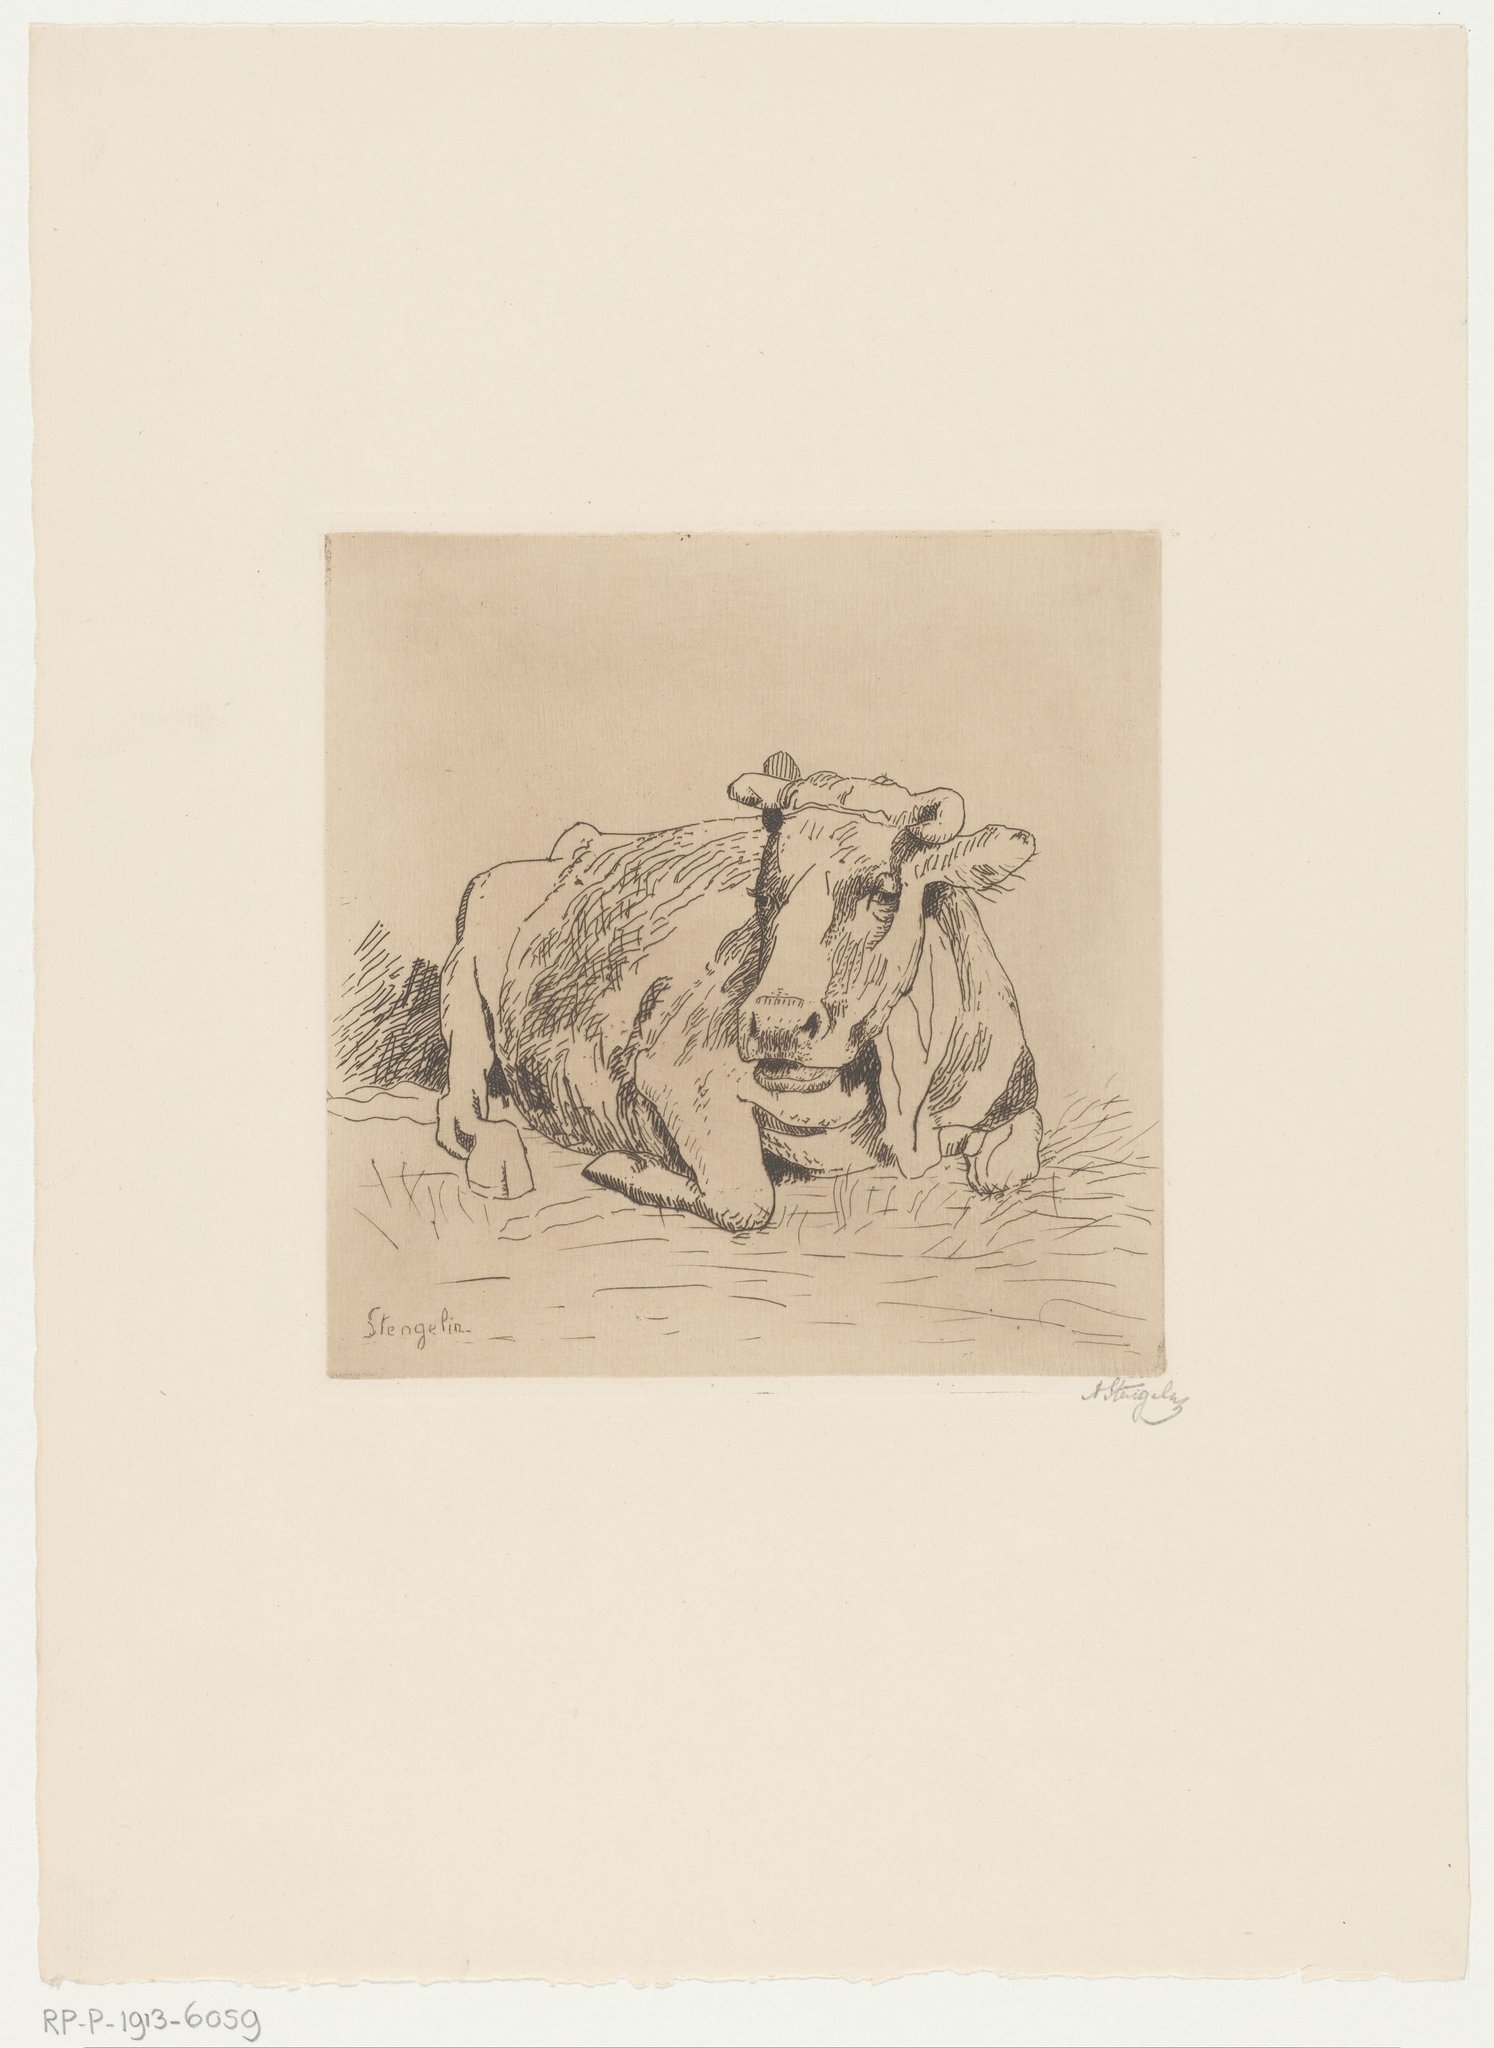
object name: print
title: Studie van een koe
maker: alphonse stengelin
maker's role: painter, print maker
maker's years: 1852-1938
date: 1862-1913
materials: paper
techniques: etching, intaglio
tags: cow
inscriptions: collector's mark: Lugt 2233